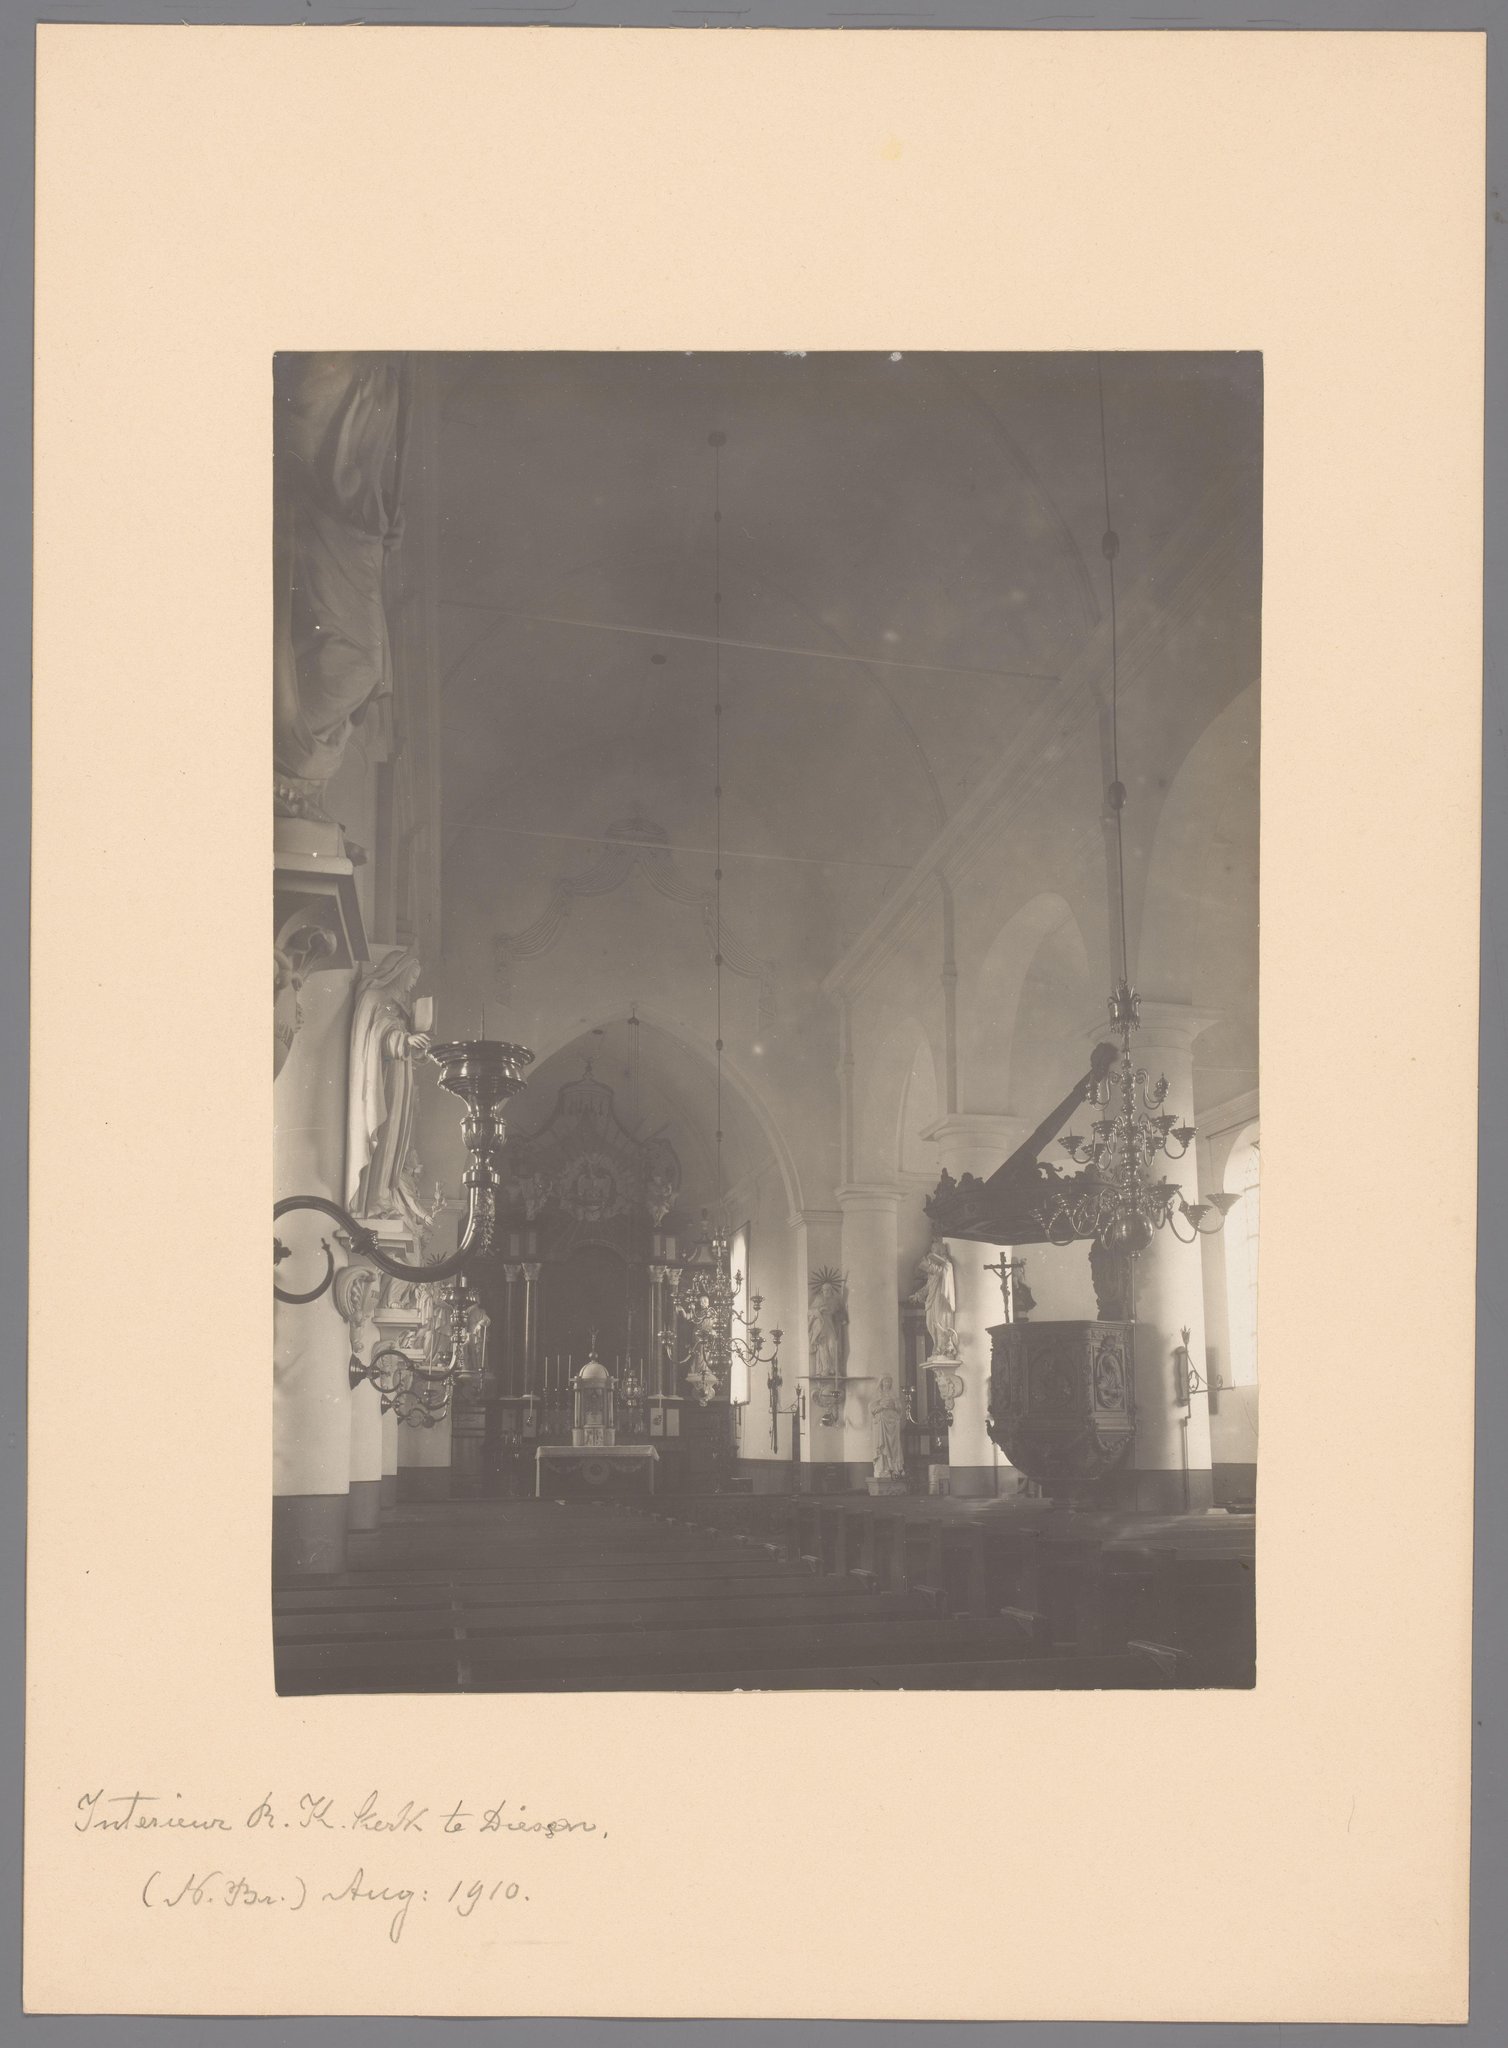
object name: photograph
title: Interieur van de Sint-Willibrorduskerk te Diessen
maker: anoniem (monumentenzorg)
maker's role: fotograaf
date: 1910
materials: cardboard, photographic support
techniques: gelatin silver print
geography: diessen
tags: interior of church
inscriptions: annotation: ‘Interieur R.K. Kerk te Diessen/ (N.Br.) Aug: 1910’